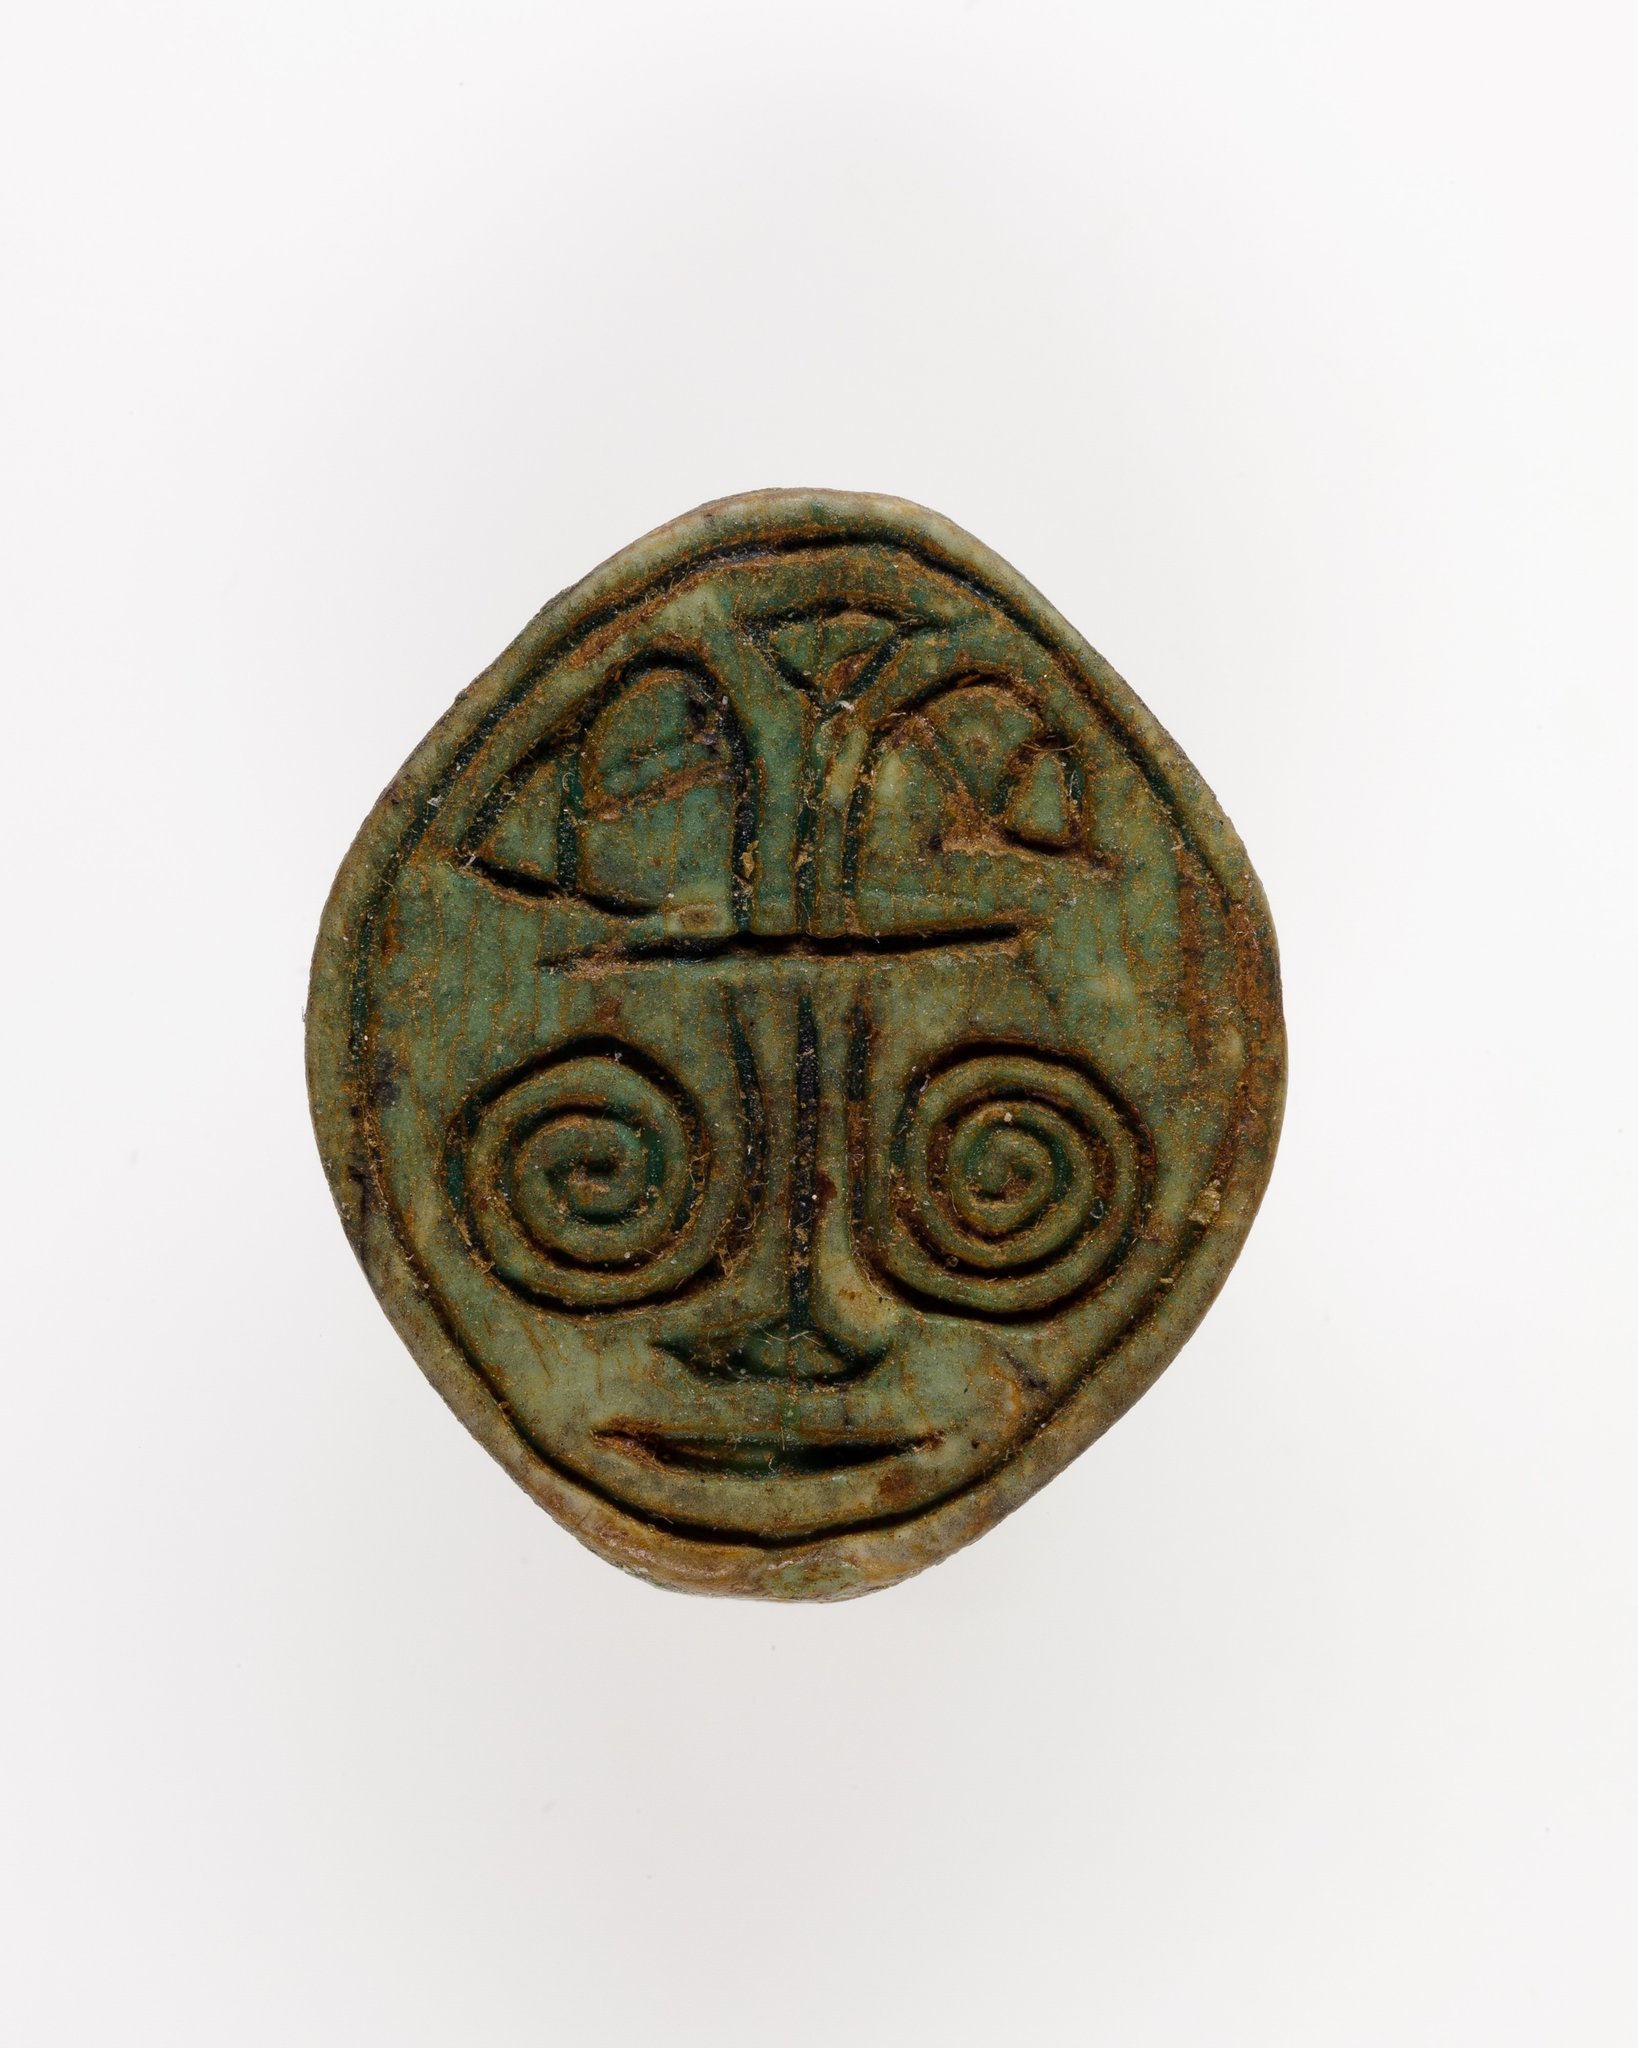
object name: scarab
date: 1981-1295 BCE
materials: stone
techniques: glazing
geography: egypt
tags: scarabs